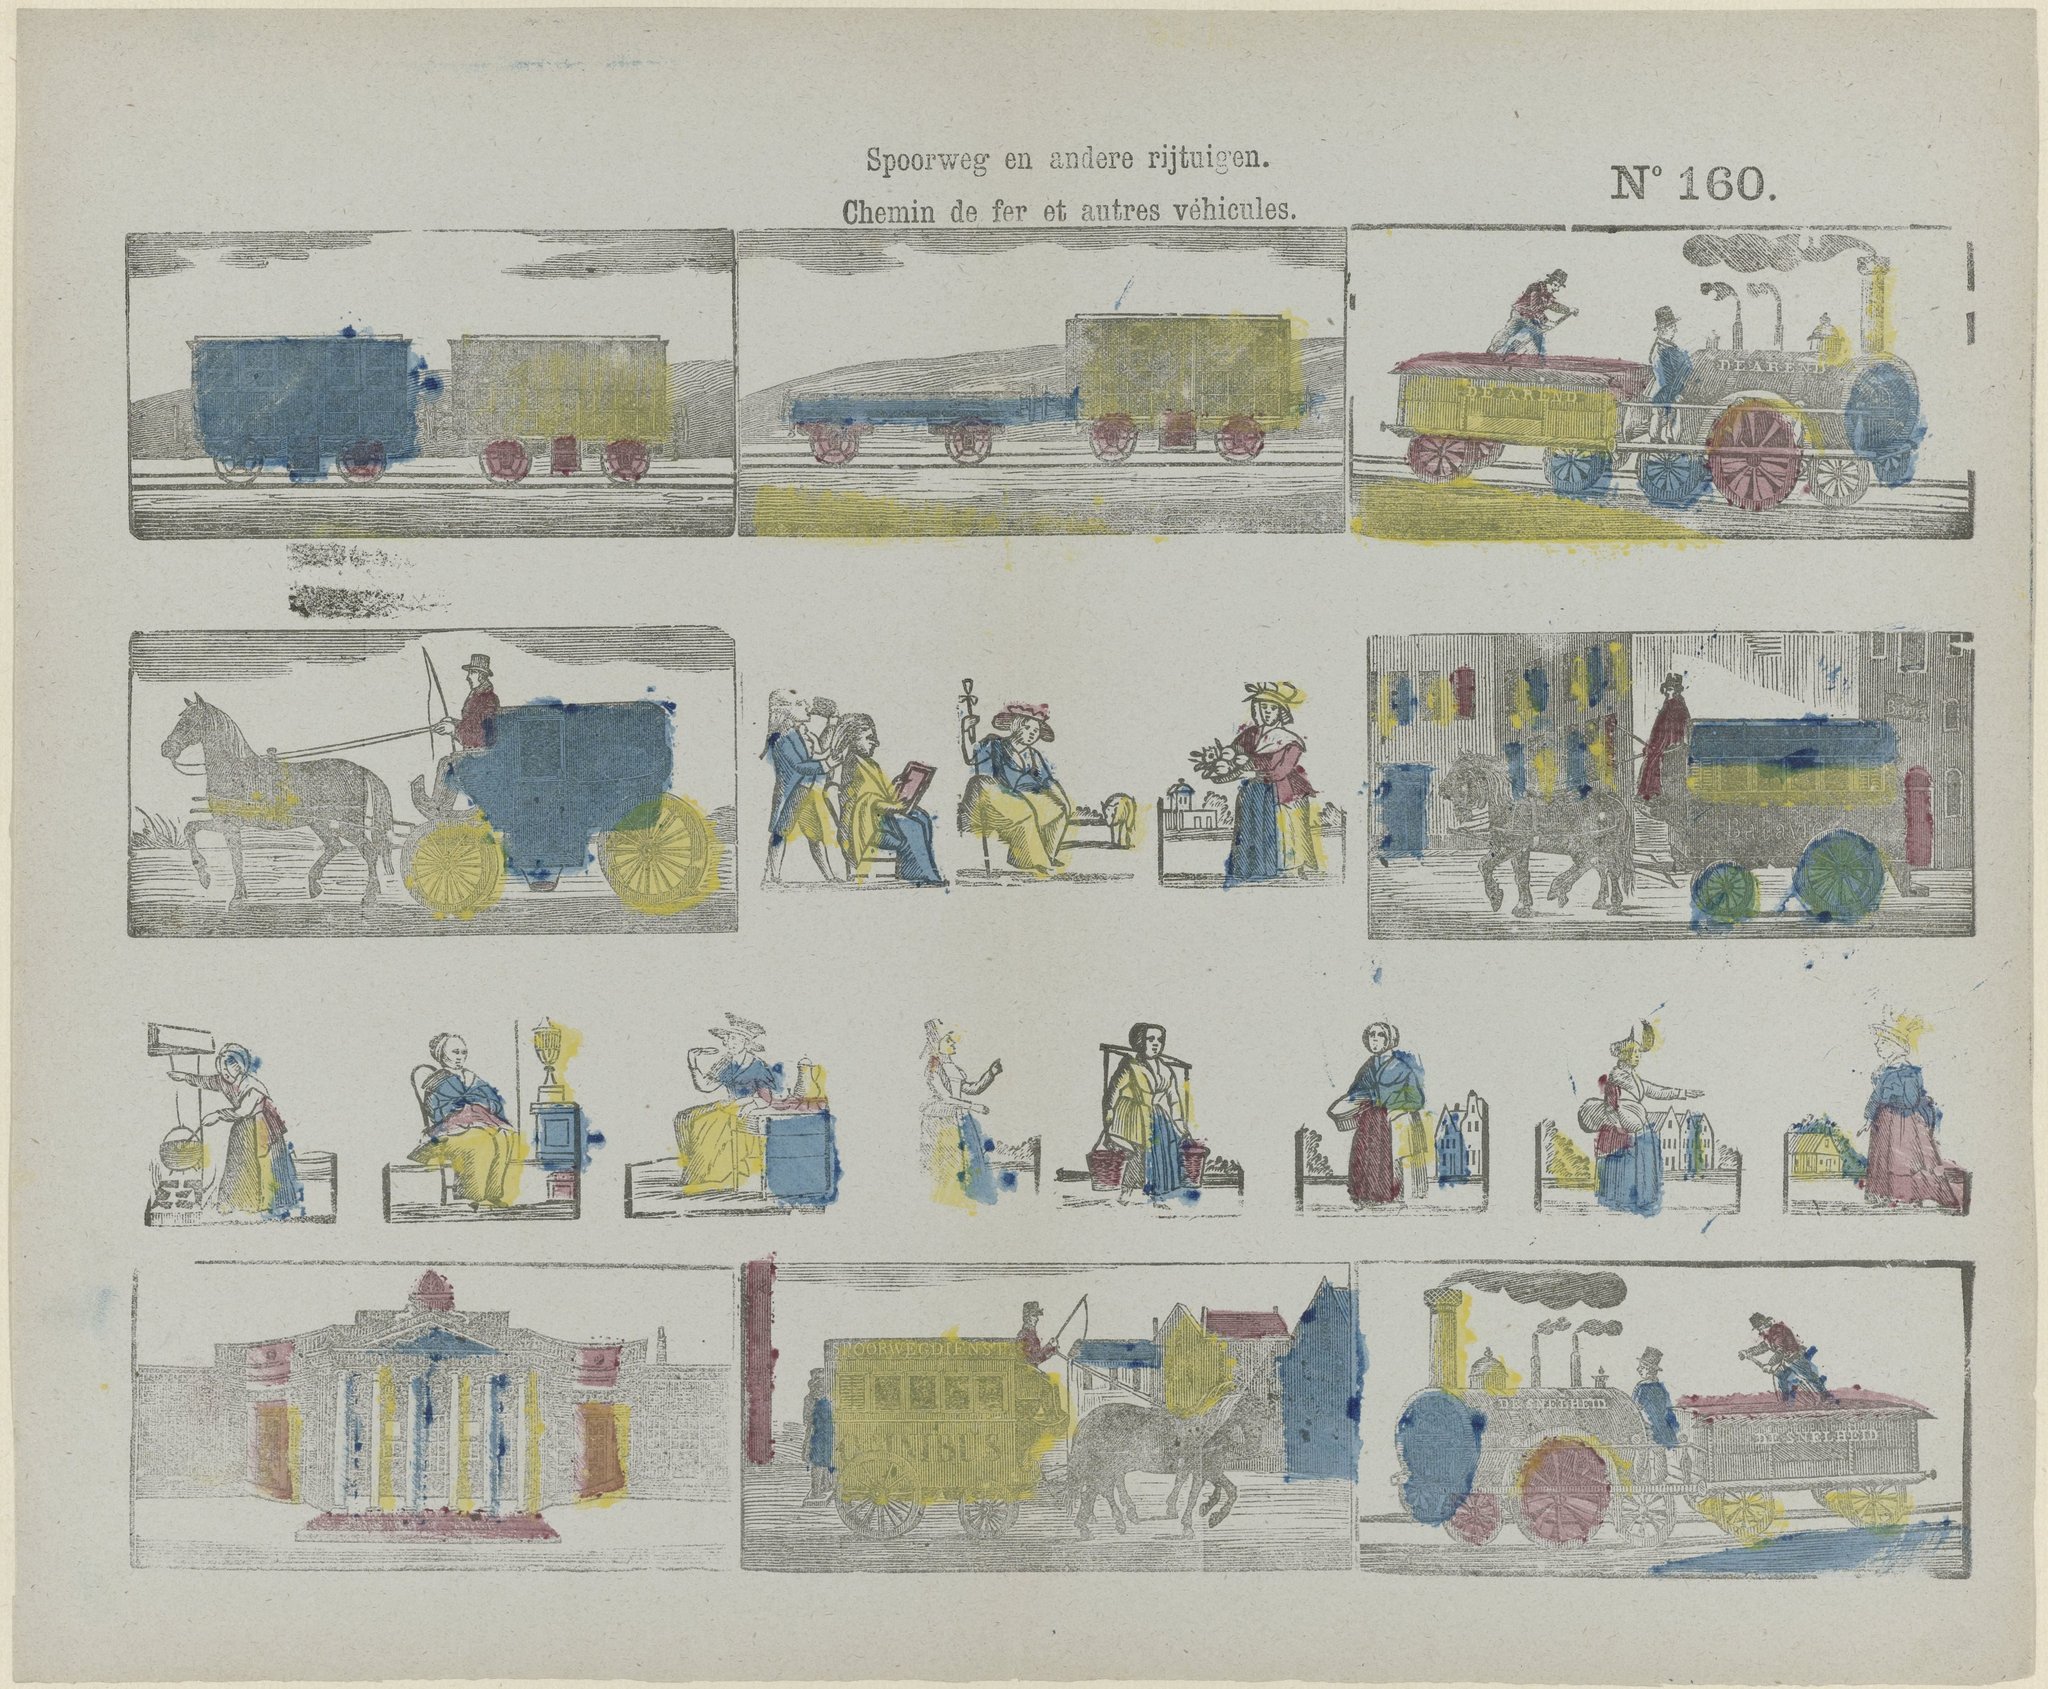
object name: print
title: Spoorweg en andere rijtuigen / Chemin de fer et autres véhicules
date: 1827-1894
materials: paper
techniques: colour, letterpress printing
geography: schaarbeek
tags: four-wheeled, animal-drawn vehicle, e.g.: cab, carriage, coach, characters (human types), railway, train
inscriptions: collector's mark: Lugt 2760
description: Blad met 19 voorstellingen van verschillende voertuigen en figuren. Genummerd rechtsboven: No 160.